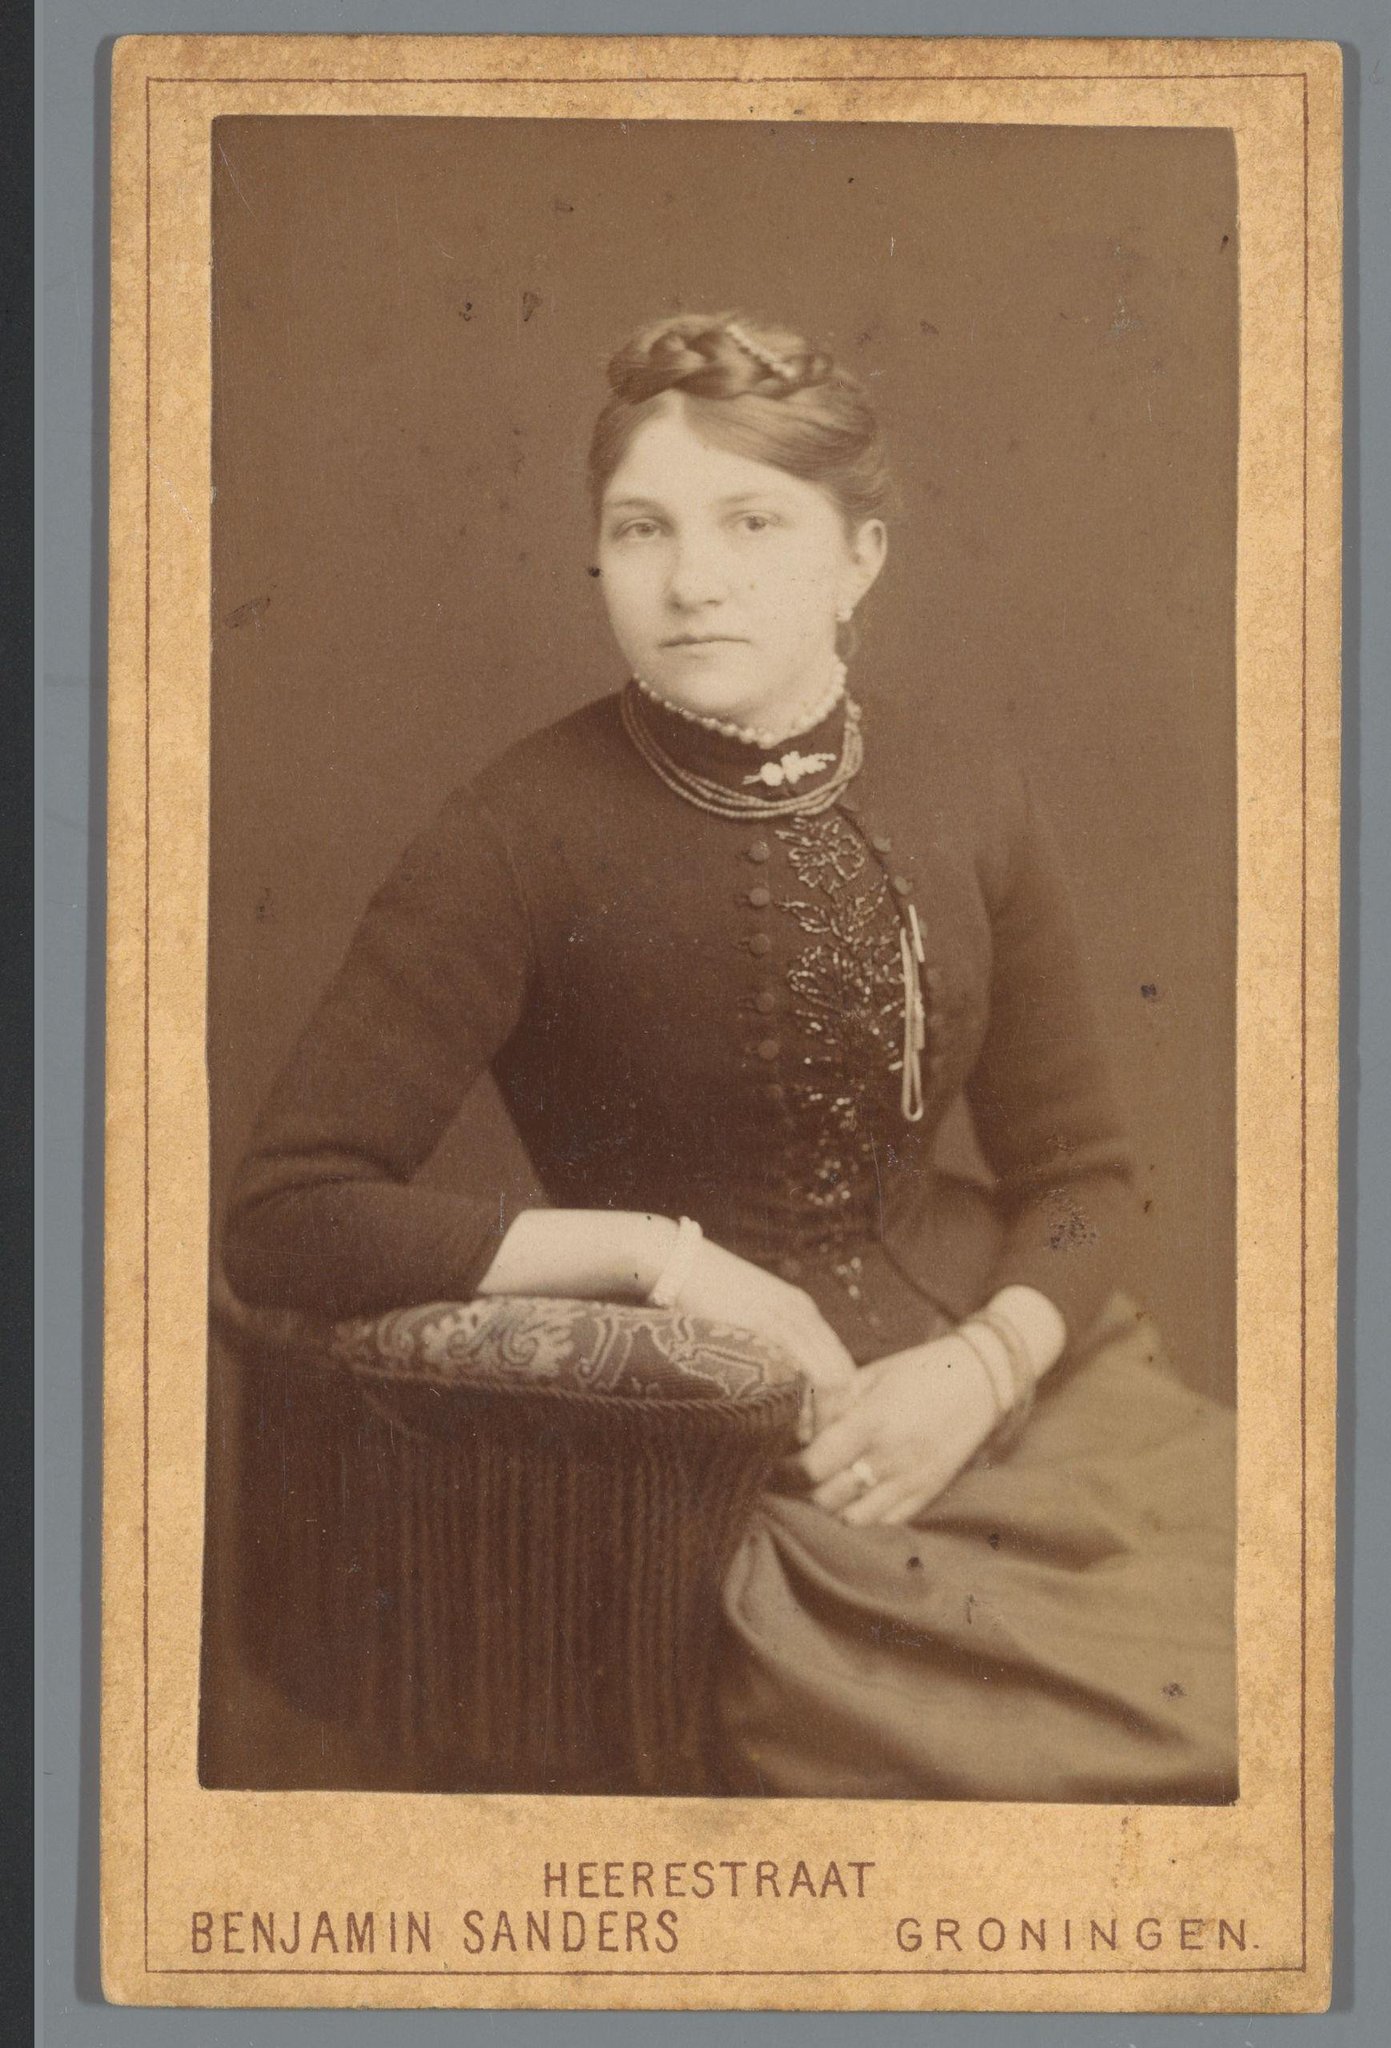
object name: carte de visite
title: Portret van een onbekende vrouw, aangeduid als mevrouw Heenstra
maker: benjamin sanders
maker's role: fotograaf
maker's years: 1841-1889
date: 1880-1889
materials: cardboard, paper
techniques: albumen print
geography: groningen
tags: historical persons - bb - woman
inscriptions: inscription: ‘Heemstra/ get. met Huizinga/ Uithuizen’, inscription: ‘ETABLISSEMENT DE PHOTOGRAPHIE/ BENJAMIN SANDERS/ GRONINGEN/ Heerestraat F. 306,/ INGANG TOT HET ATELIER IN DE/ NIEUWE MANUFACTUURWINKEL./ De plaat blijft voor nabestelling bewaard./ SPECIALE INRICHTING VOOR VERGROOTINGEN NAAR/ ALLE PHOTOGRAFIEN.’